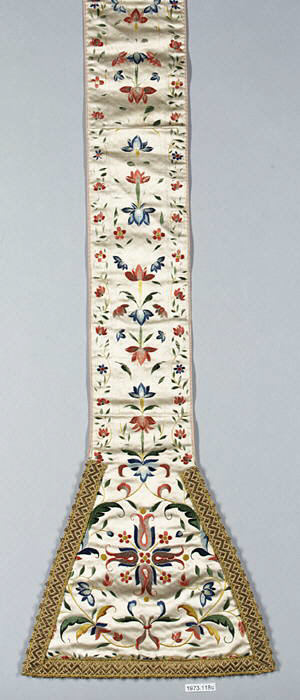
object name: stole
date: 1767-1800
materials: silk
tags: flowers